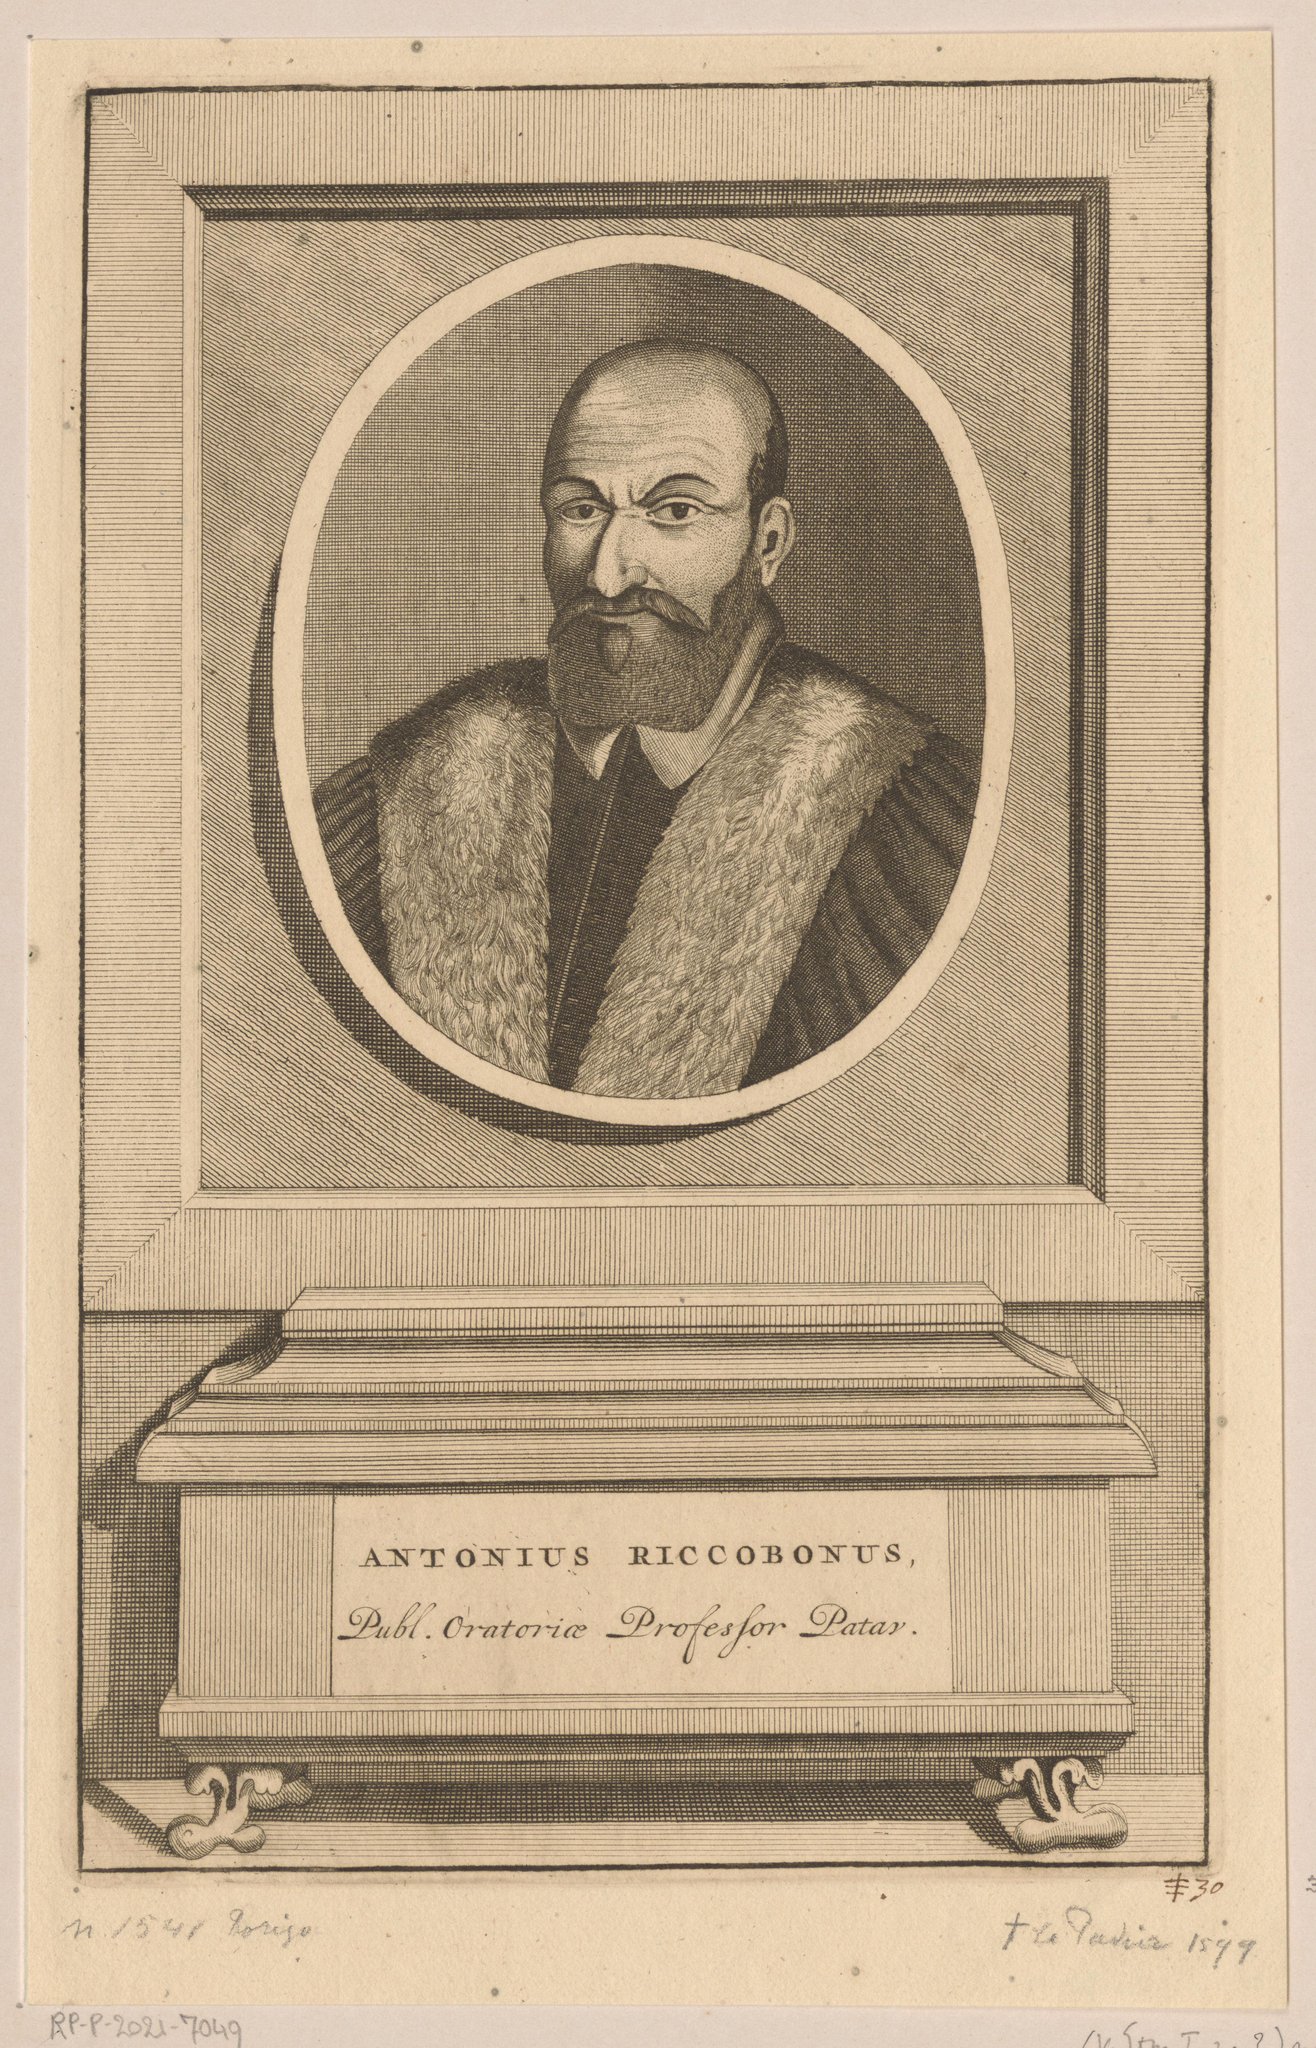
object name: print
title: Portret van Antonio Riccoboni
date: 1668-1730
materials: paper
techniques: engraving, etching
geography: leiden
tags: historical persons